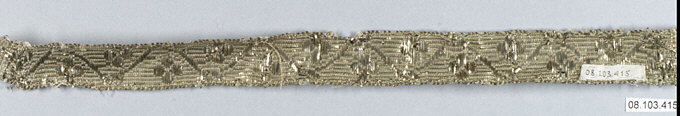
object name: galloon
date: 1701-1800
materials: metal thread